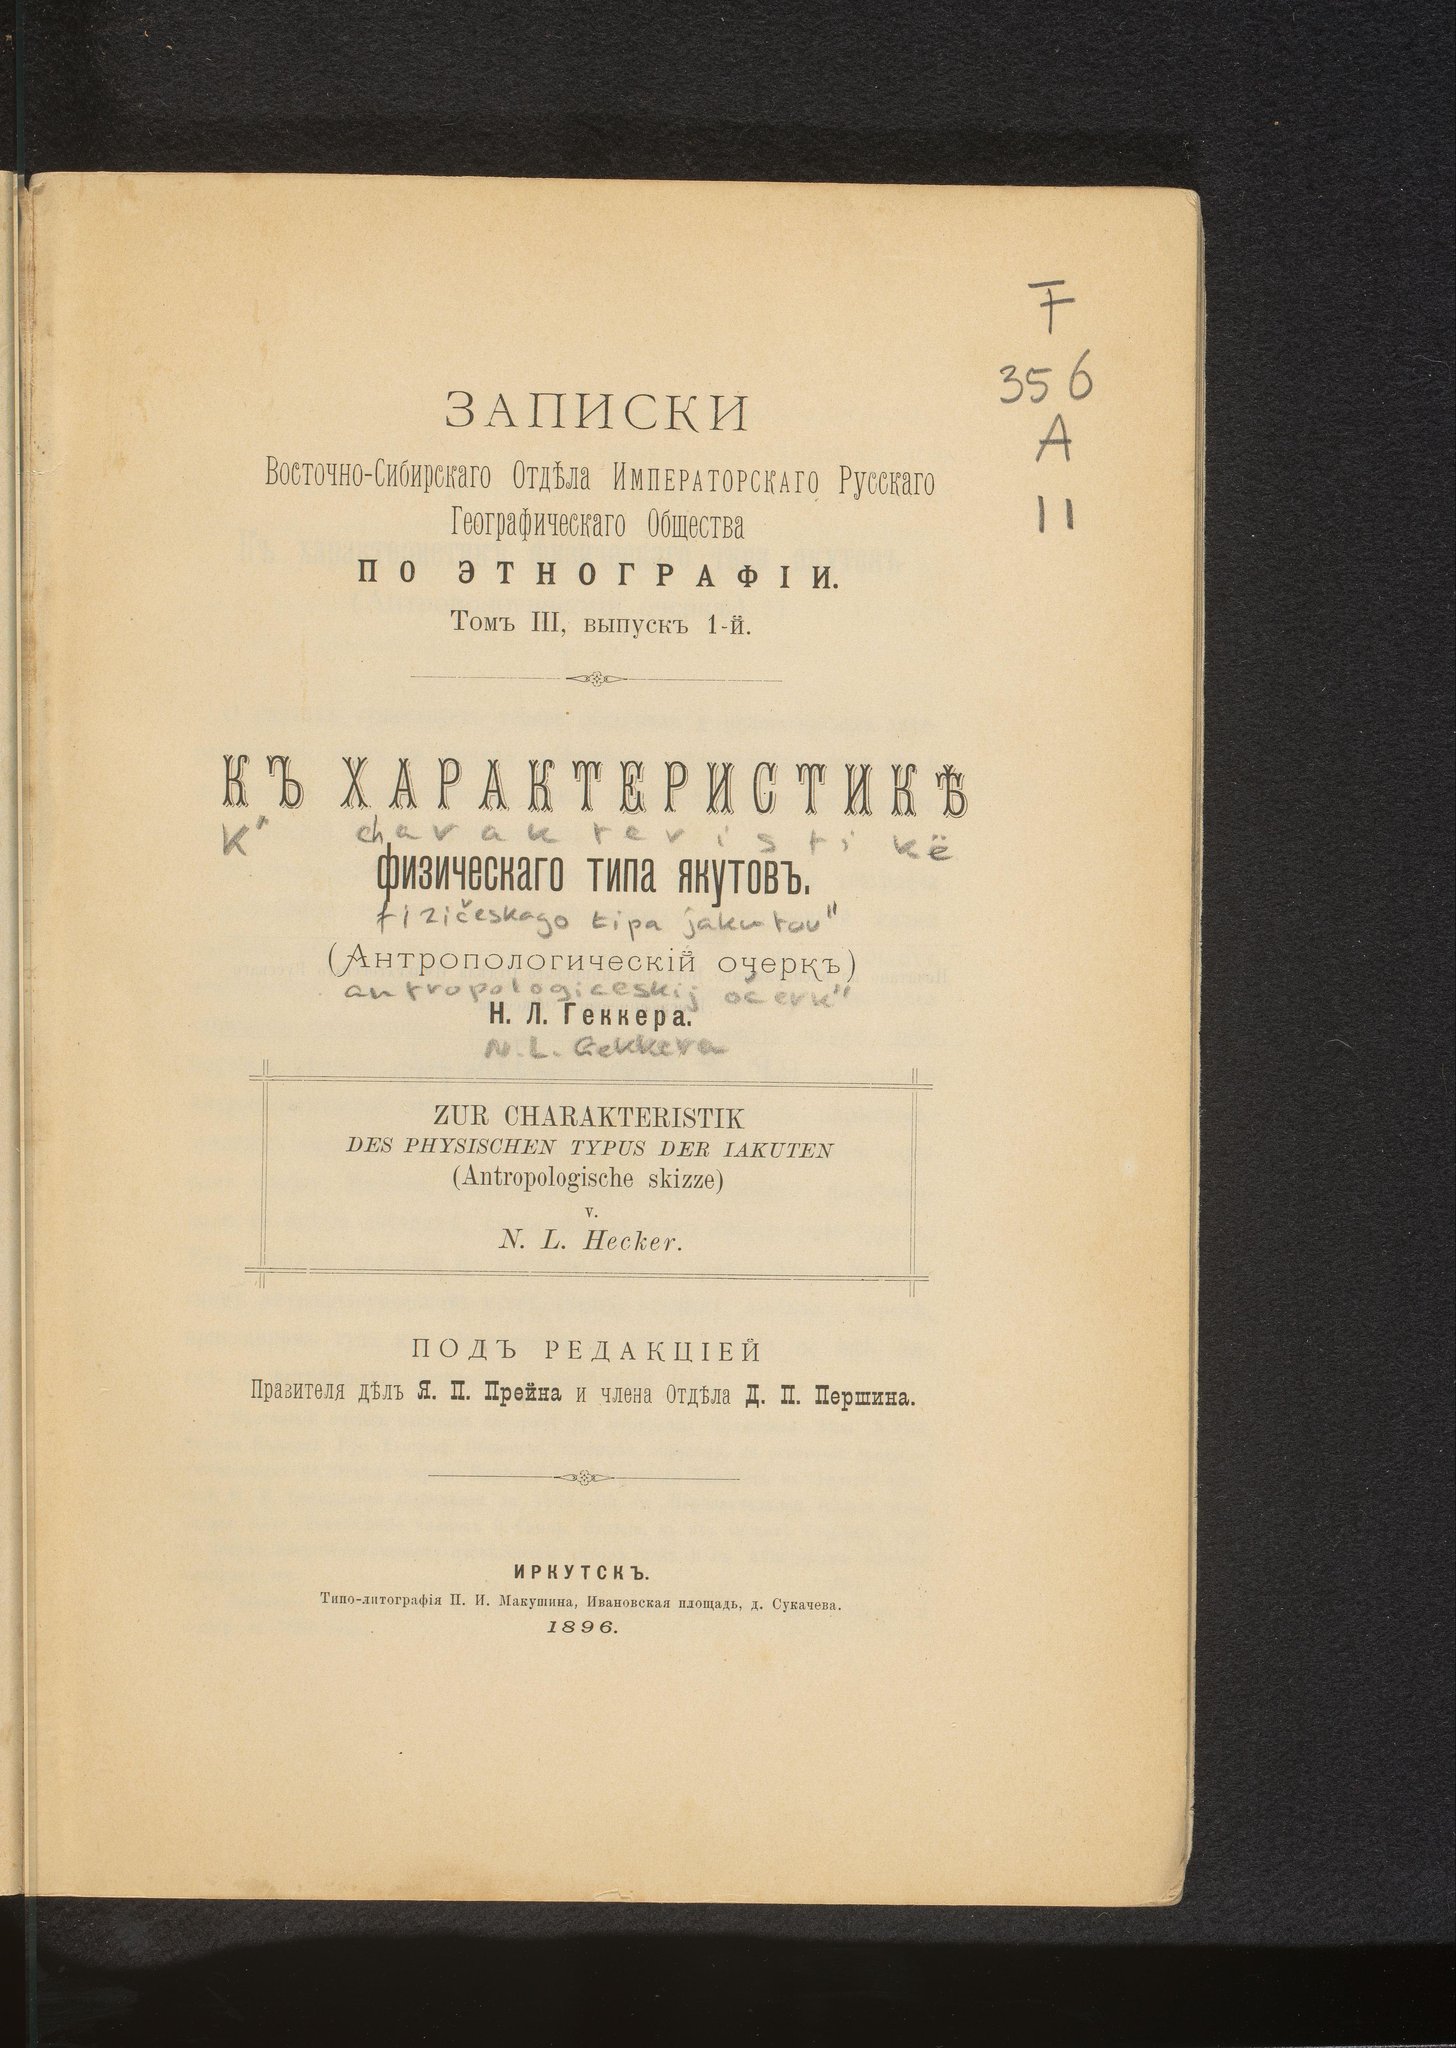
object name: book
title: K' charakteristikë fiziceskago tipa jakutov'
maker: naum leontievitsj hecker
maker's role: criticus, etnoloog, journalist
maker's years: 1861-1920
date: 1896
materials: paper, photographic support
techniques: albumen print, printing